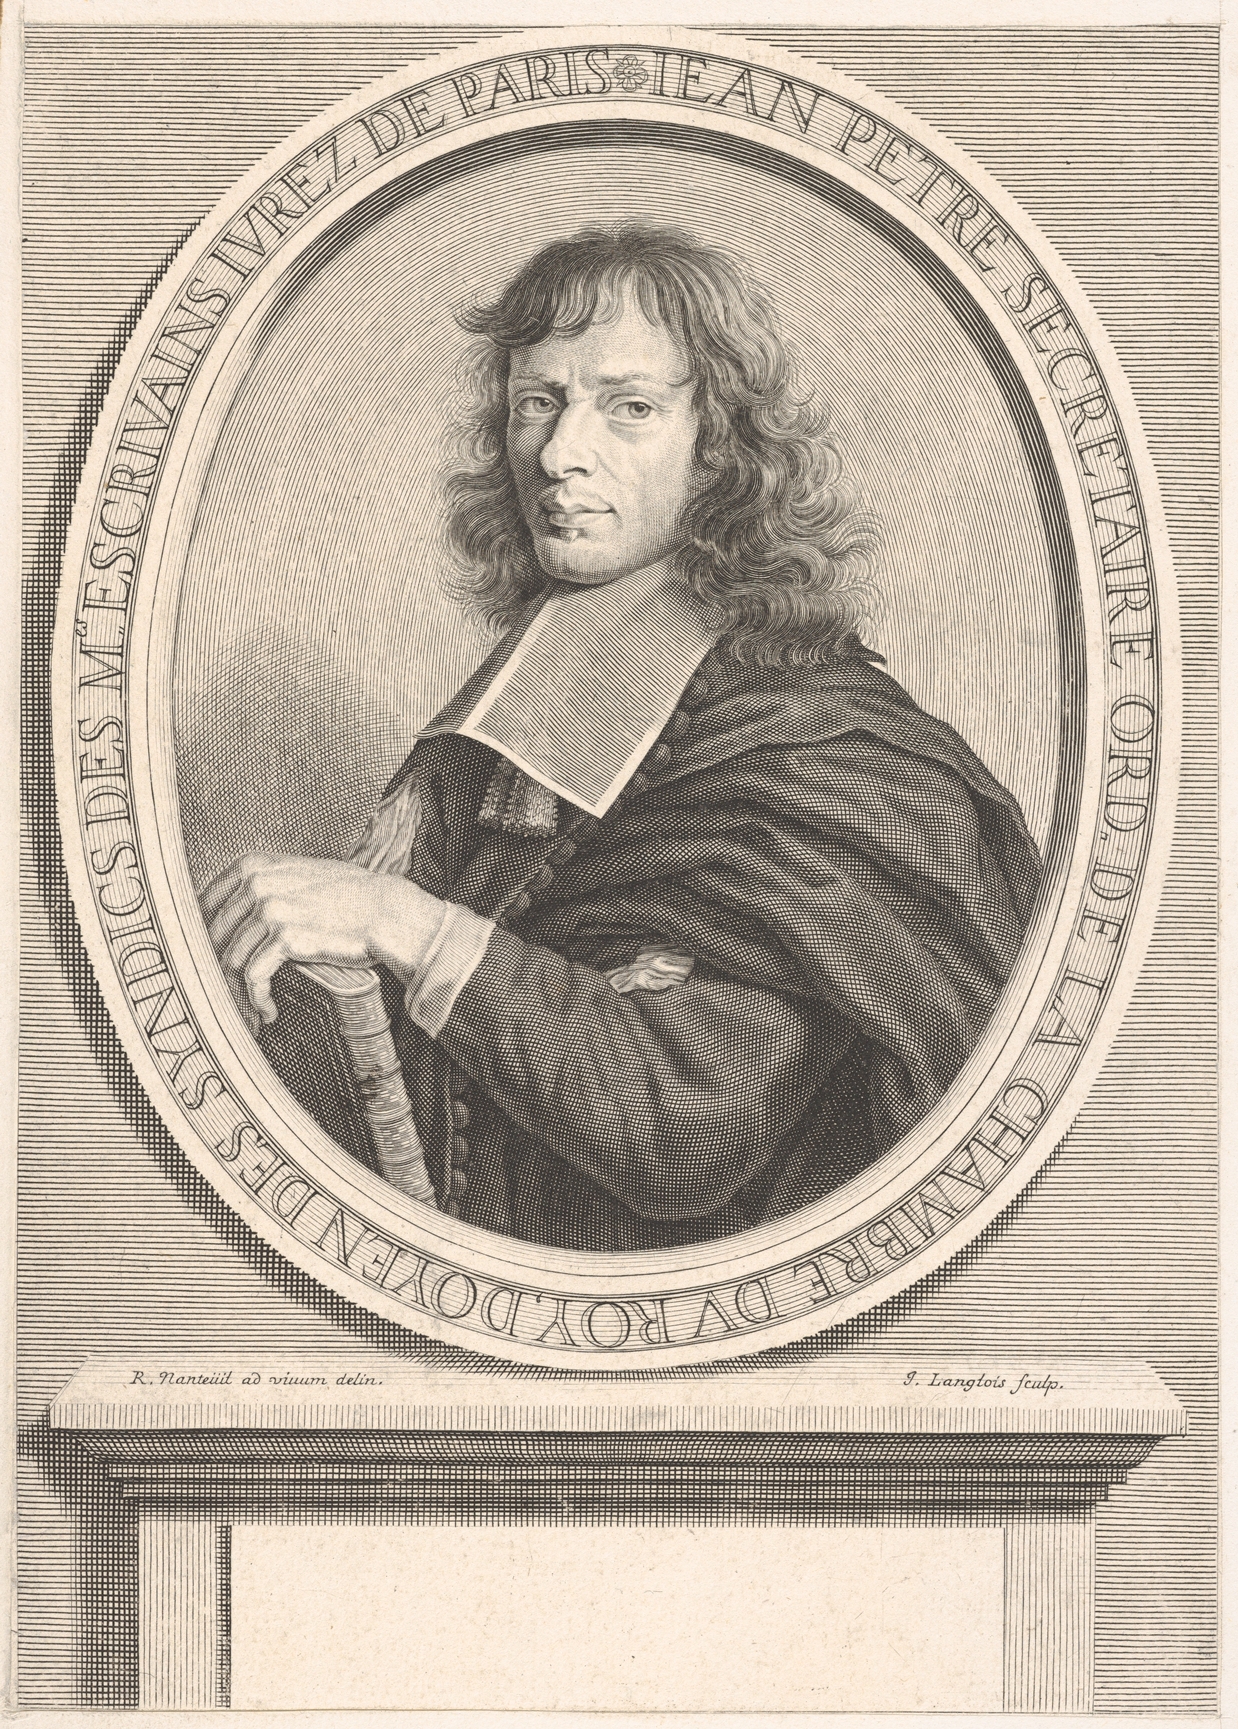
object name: print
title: Jean Petre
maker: jean langlois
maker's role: artist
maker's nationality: french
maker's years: 1649-1719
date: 1667-1733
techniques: engraving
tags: men,portraits